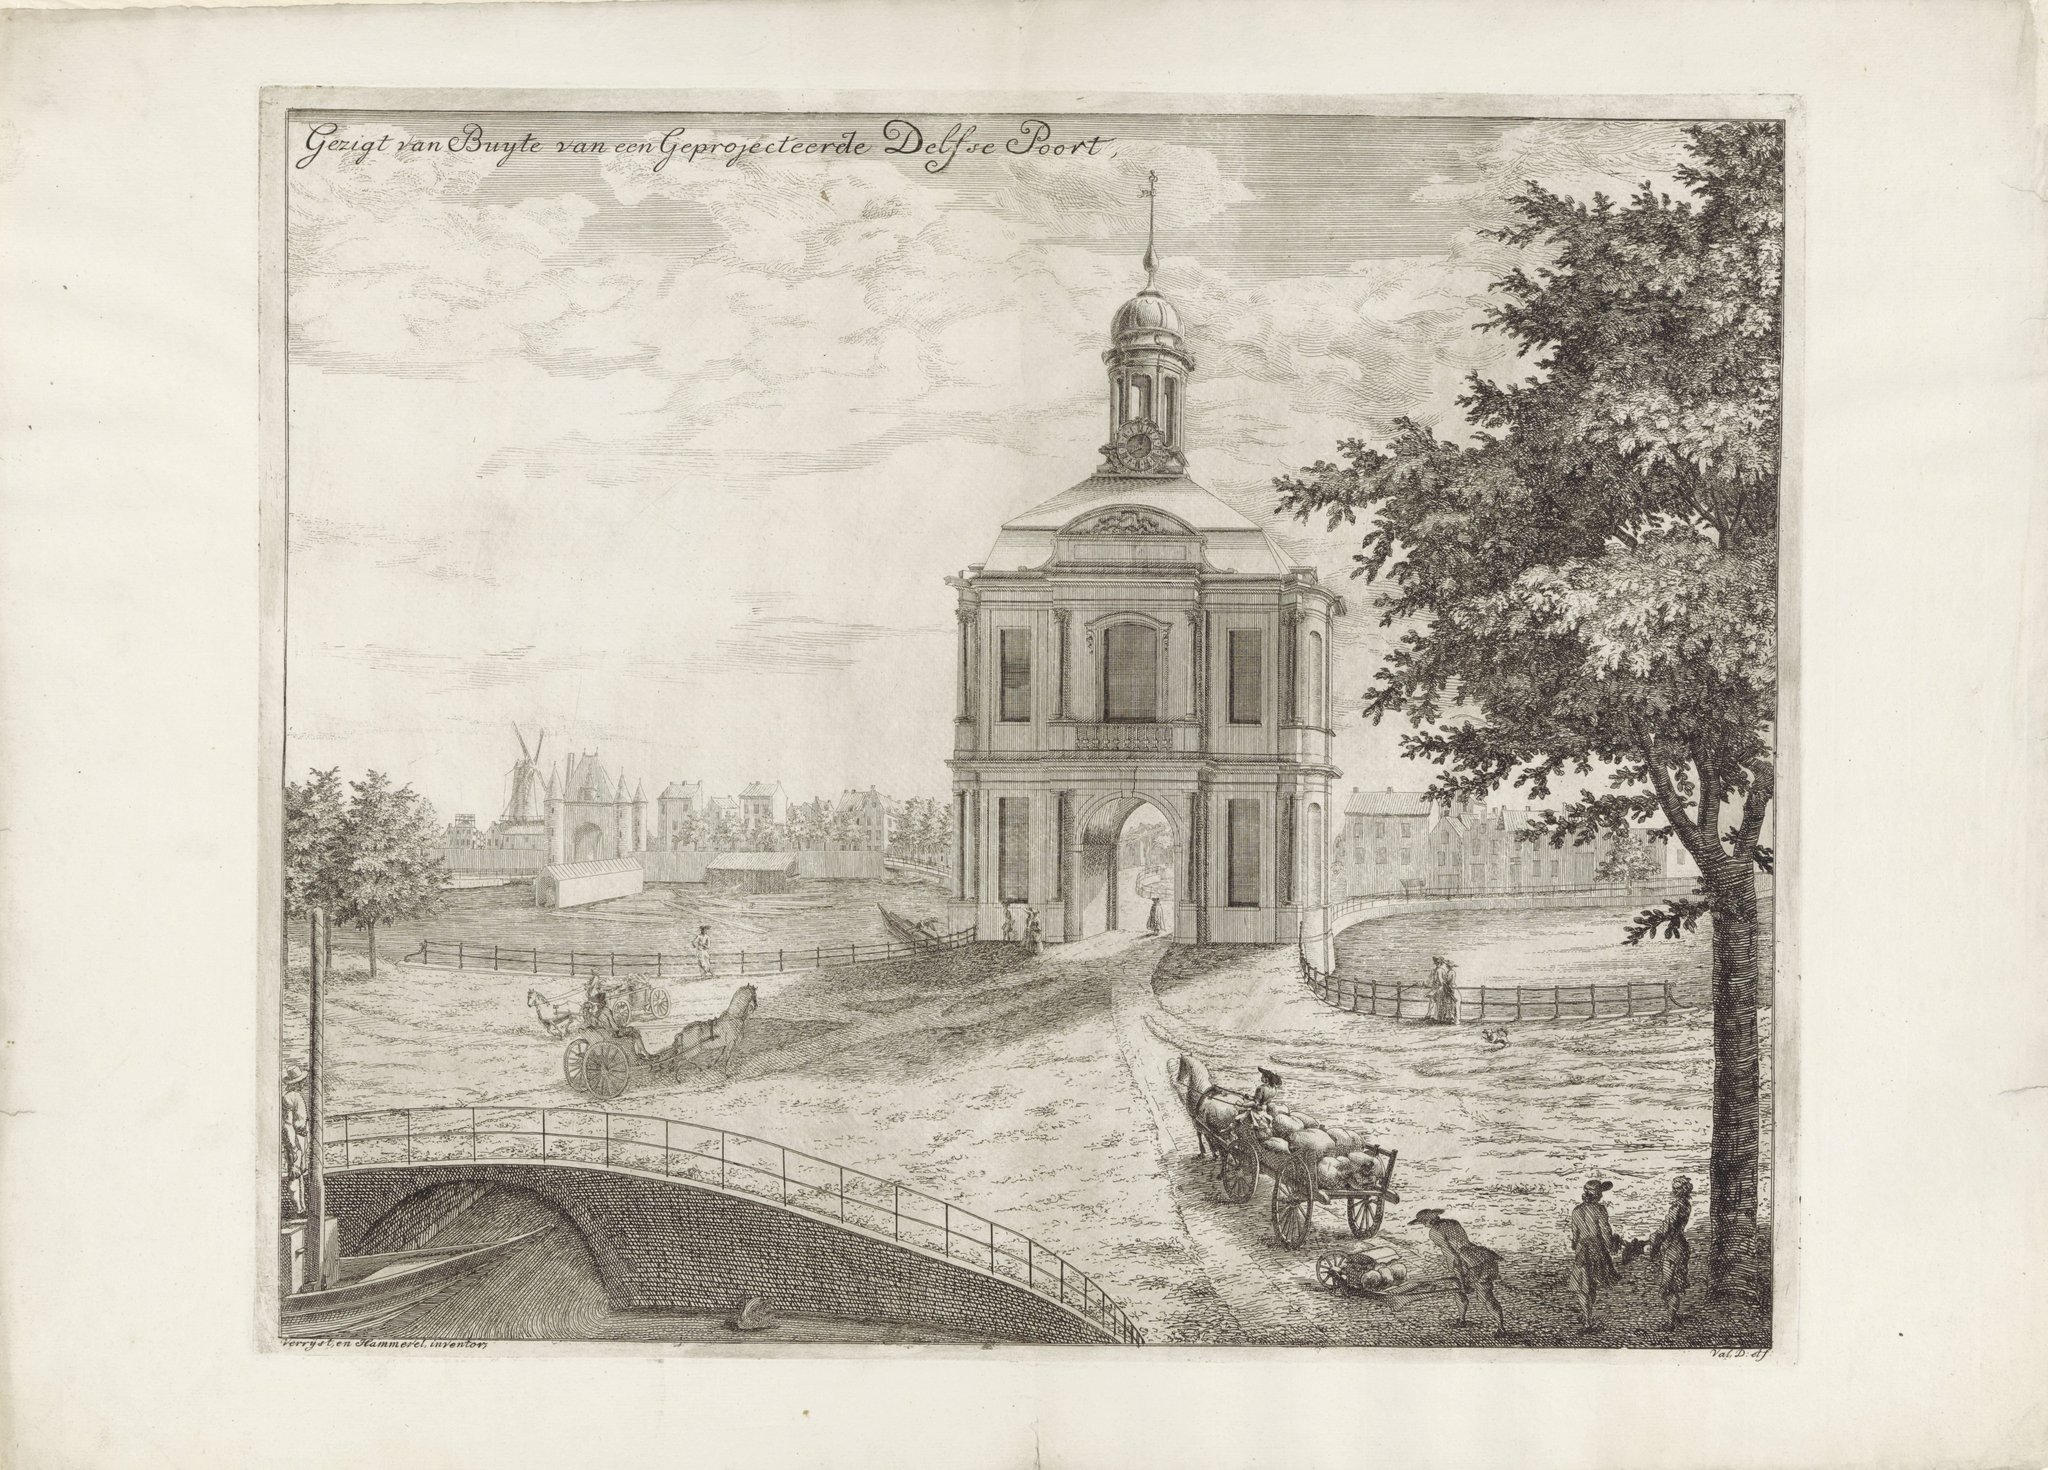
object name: print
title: Ontwerp voor een nieuwe Delftse Poort te Rotterdam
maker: auguste moreau val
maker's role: draughtsman, print maker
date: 1767-1769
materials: paper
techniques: etching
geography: netherlands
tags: wheelbarrow, city-gate, (farm) wagon, freight wagon, cart, rotterdam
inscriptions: collector's mark: Lugt 2228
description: Ontwerp voor de nieuwe Delftse poort te Rotterdam, met op de voorgrond een molenaarskar, een man met een kruiwagen en een paar wandelaars.